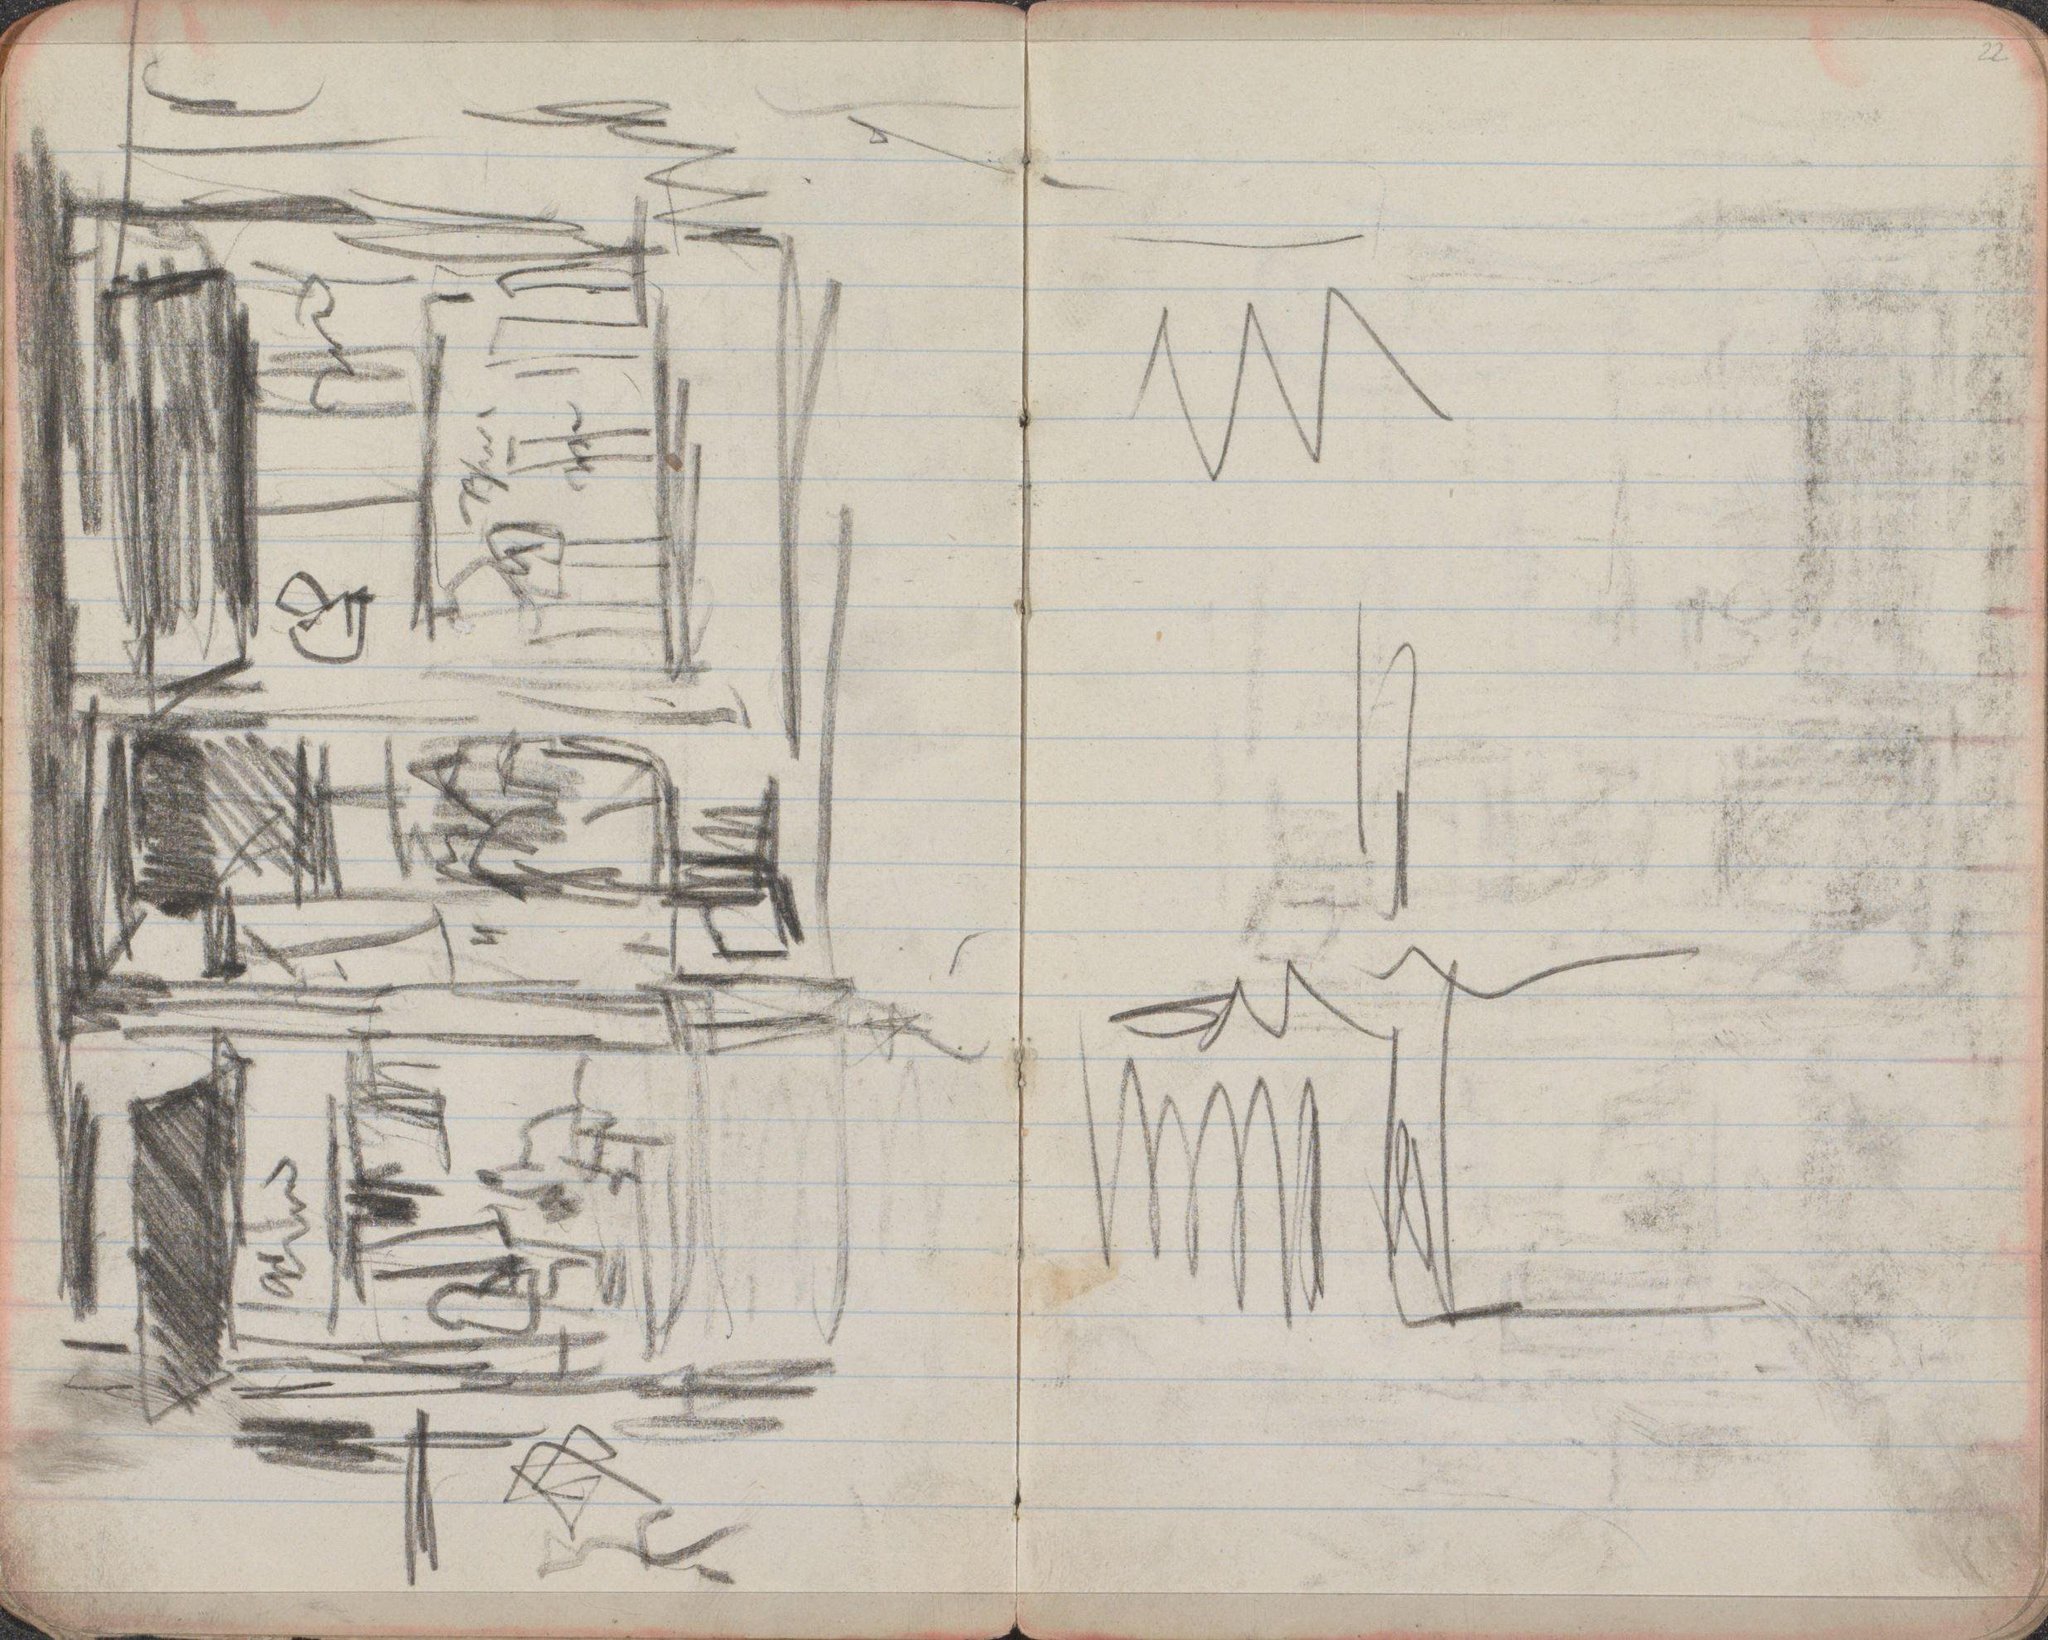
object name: sketchbook leaf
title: Pui van een winkel op de Nieuwendijk in Amsterdam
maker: george hendrik breitner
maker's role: draughtsman, painter, print maker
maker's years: 1857-1923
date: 1892-1900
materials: chalk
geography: amsterdam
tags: shop-window, show-window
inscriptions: kleurnotitie, handgeschreven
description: Pagina 21 en pagina 22 uit een schetsboek met 38 bladen.